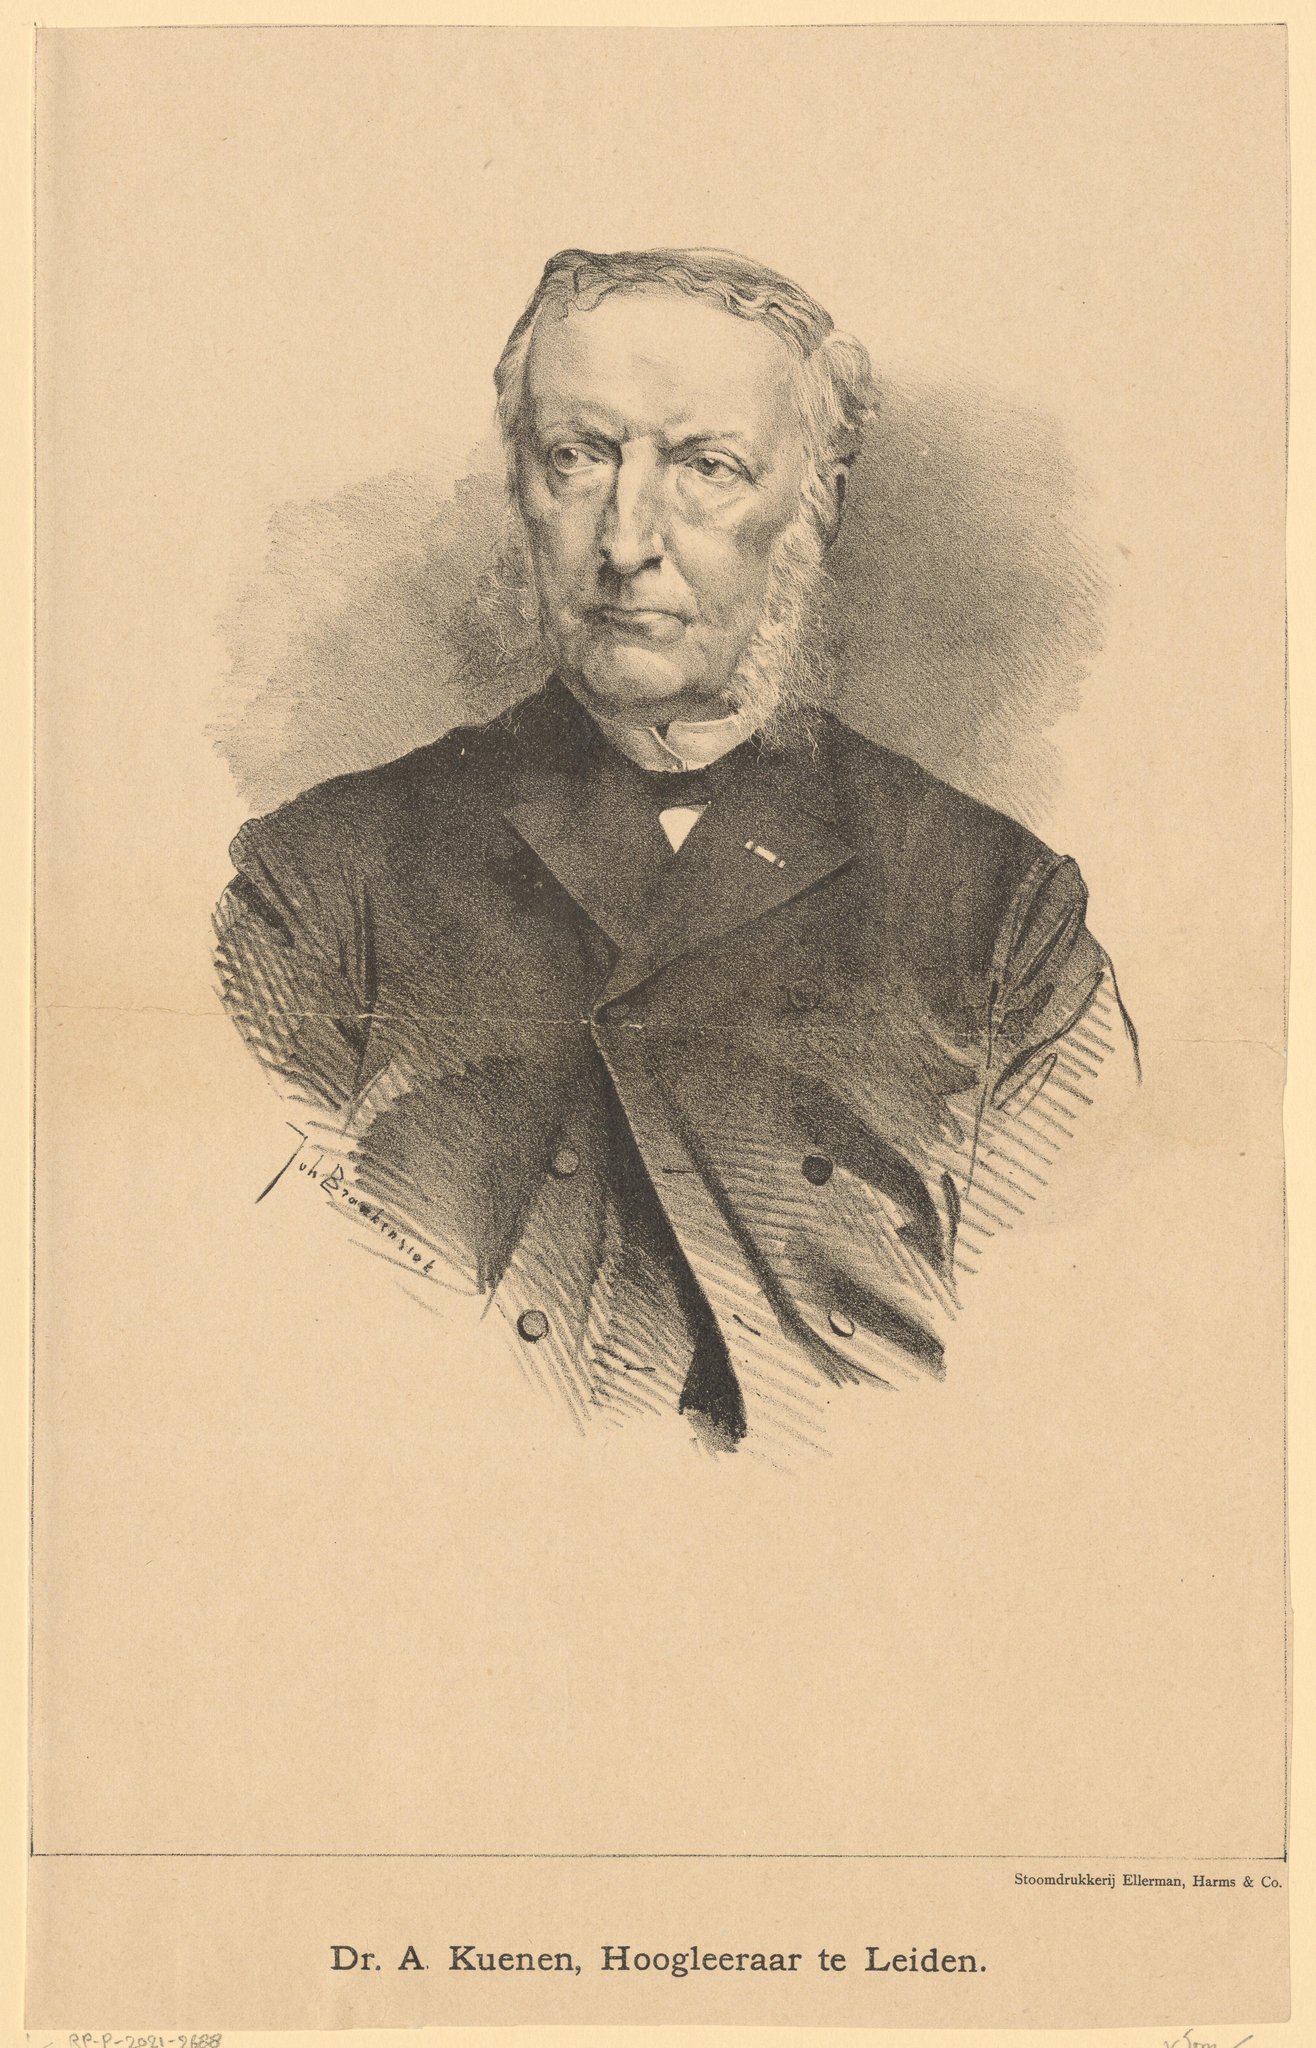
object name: print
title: Portret van Abraham Kuenen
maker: johan braakensiek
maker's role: draughtsman, print maker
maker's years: 1858-1940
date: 1889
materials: paper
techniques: lithograph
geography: amsterdam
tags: haarlem, leiden, historical persons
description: Prent waarschijnlijk het bijvoegsel van: De Amsterdammer. Weekblad voor Nederland, 21 april 1889.